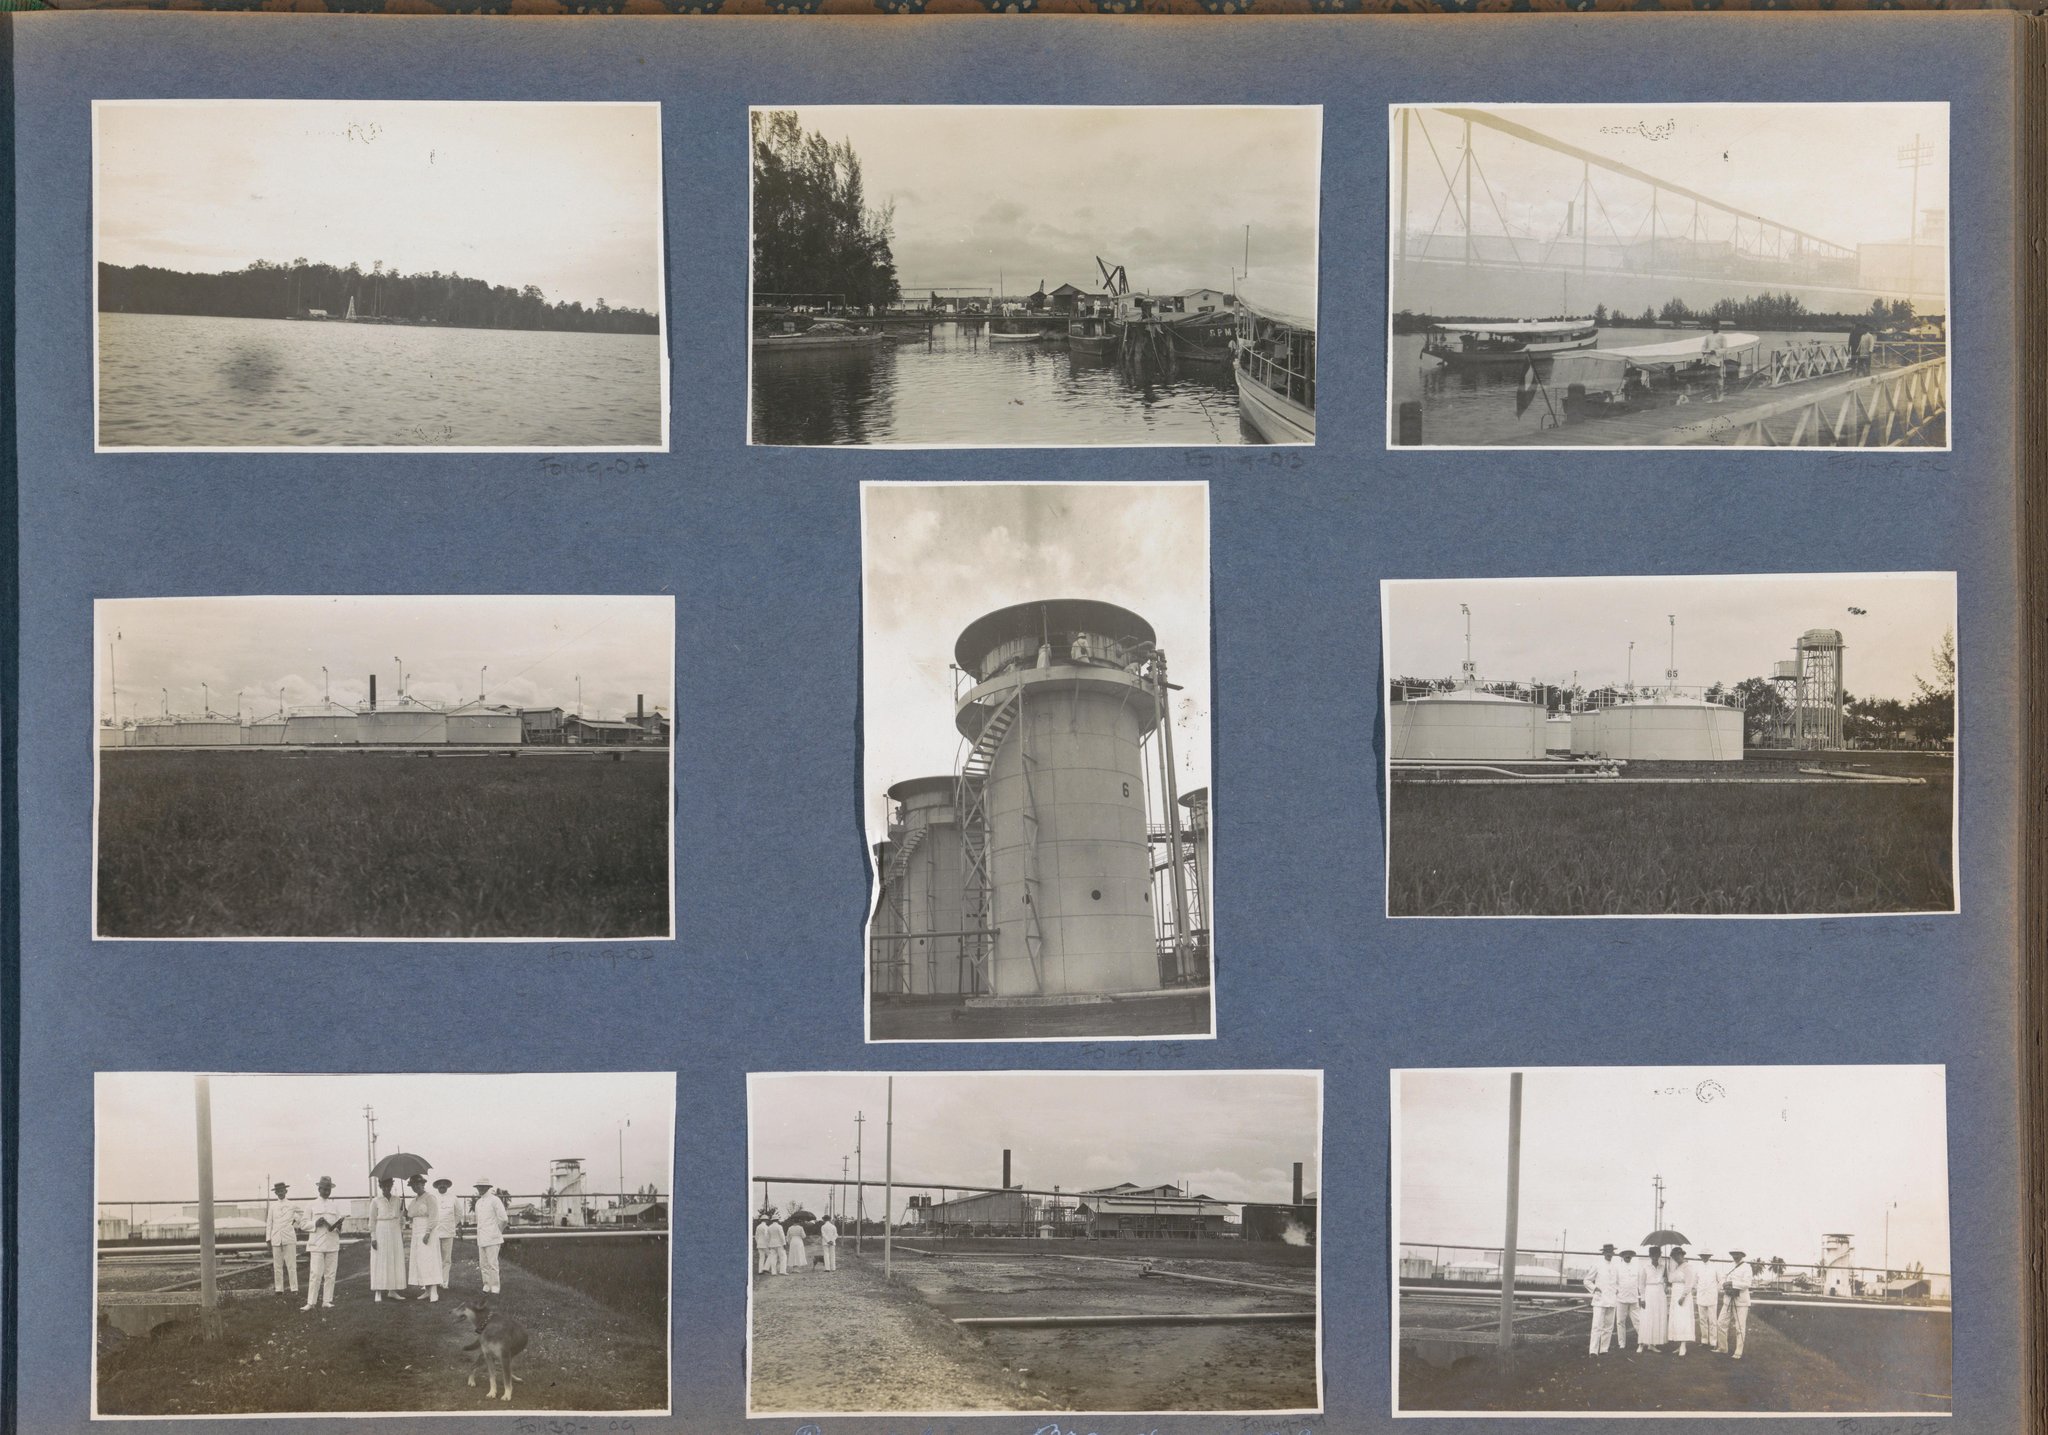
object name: photograph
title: Groep mannen en vrouwen bij een fabriekscomplex voor oliewinning te Pangkalan-Brandan op Sumatra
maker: Anonymous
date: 1900-1920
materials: paper, photographic support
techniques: gelatin silver print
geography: sumatra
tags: oil; oil refinery, sumatra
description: Onderdeel van reisalbum met foto's van bedrijvigheid en bezienswaardigheden op Sumatra en Java en van de reis naar en van Nederlands-Indië.